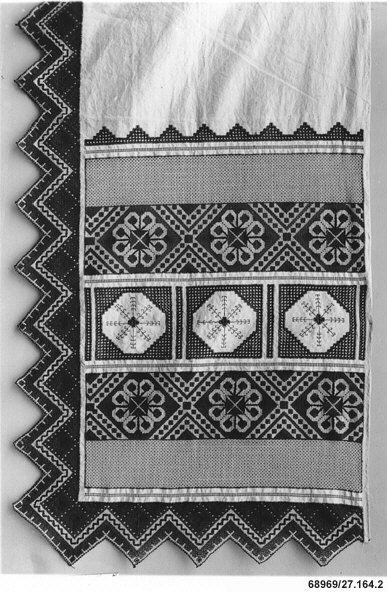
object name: scarf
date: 1801-1900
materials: linen